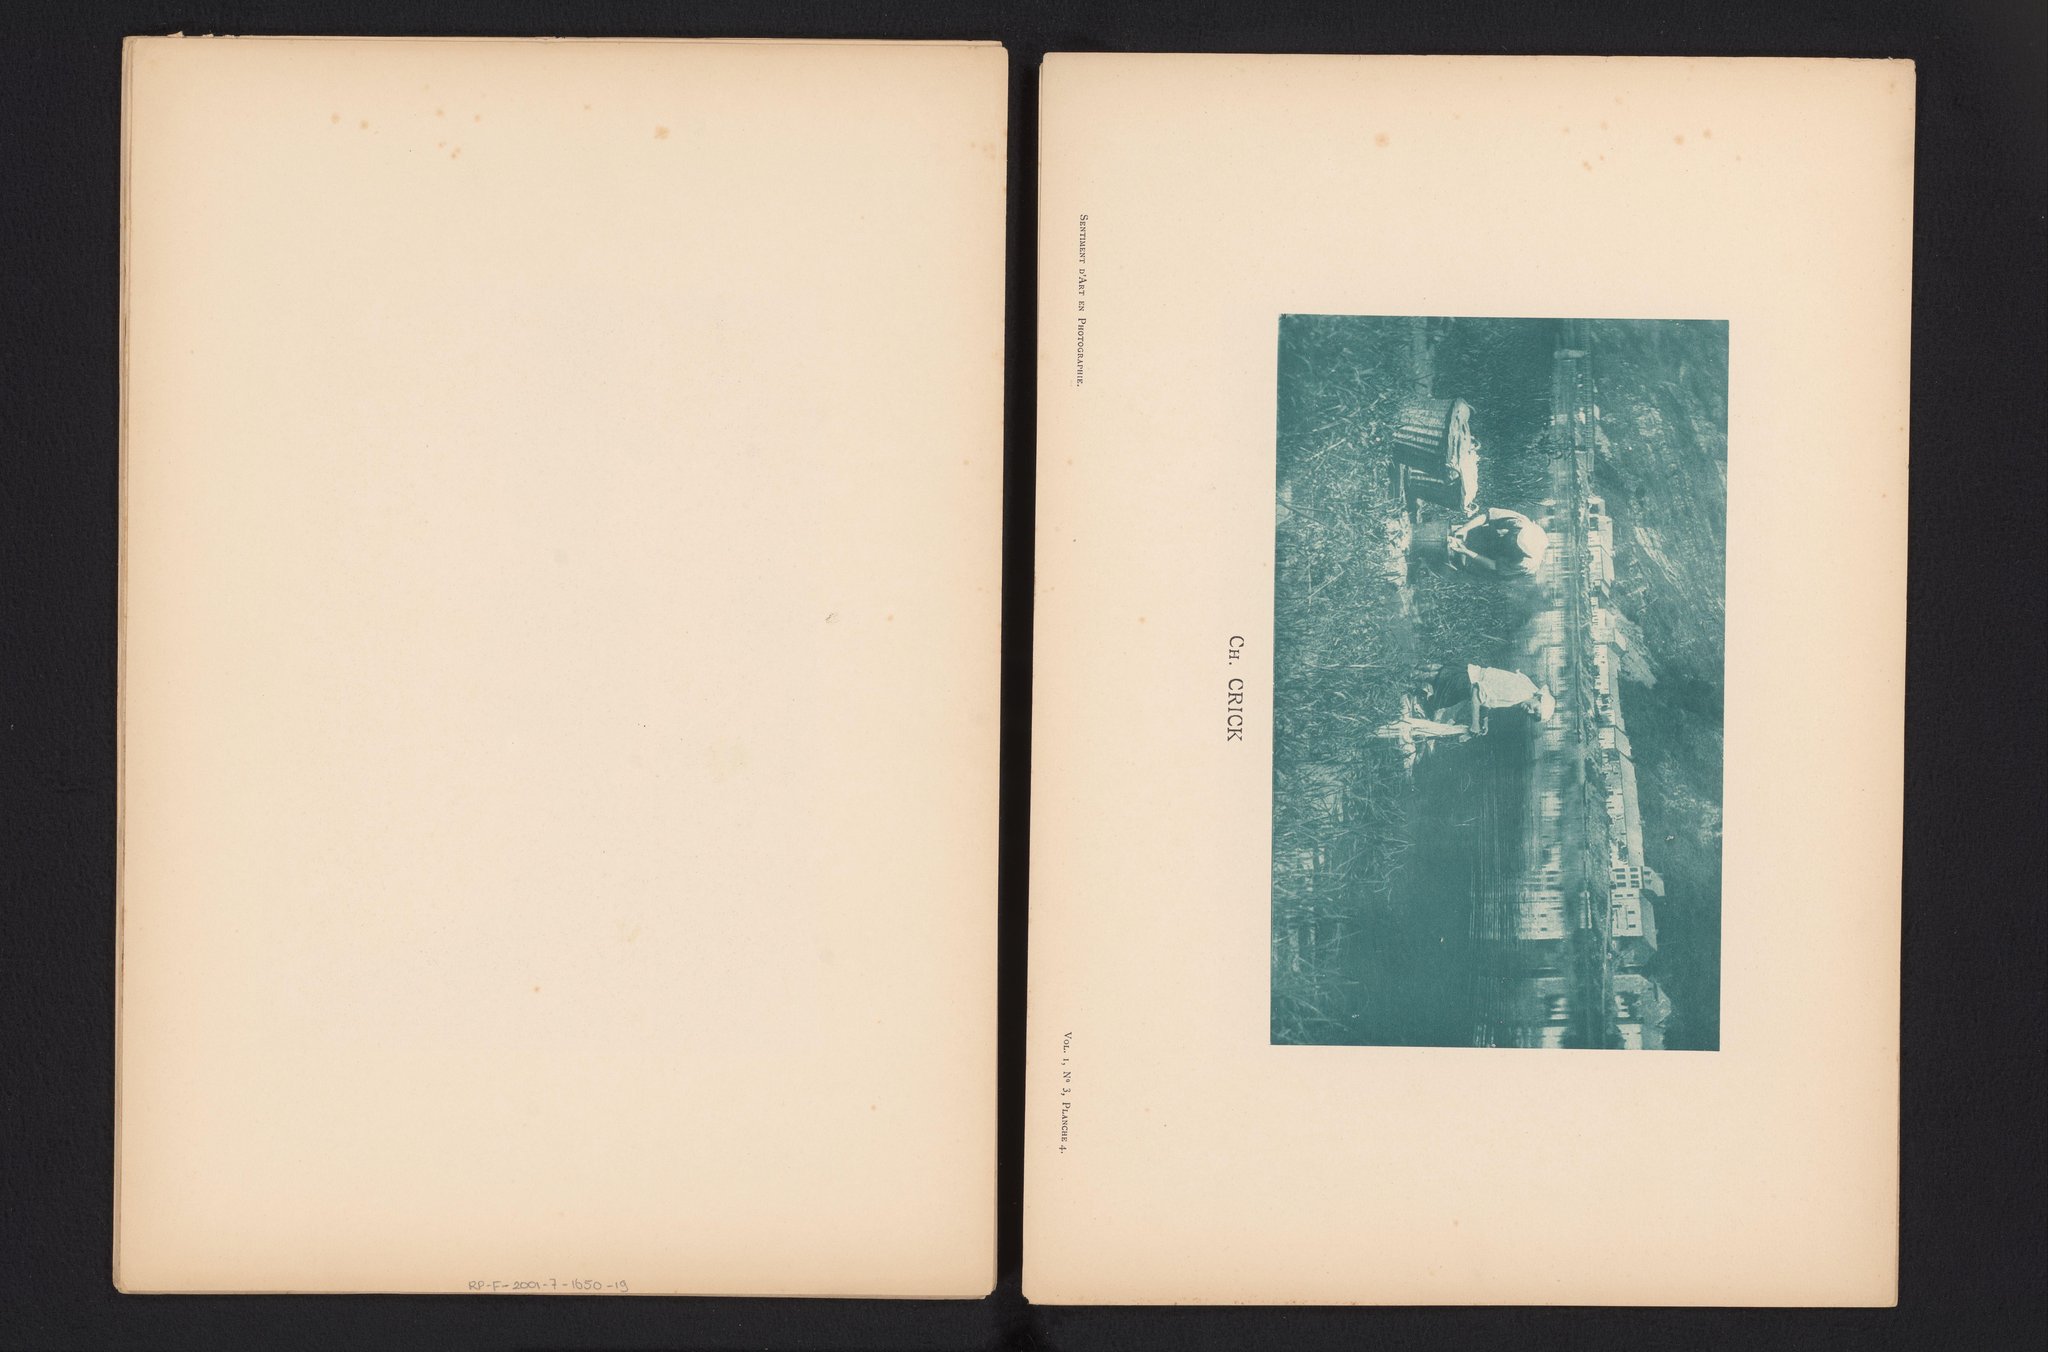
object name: photomechanical print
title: Twee vrouwen wassen kleding aan de oever van een rivier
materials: paper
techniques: photograph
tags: river bank, laundering, adult woman (+ two persons)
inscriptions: number: ‘Vol. 1, No 3, Planche 4.’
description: Deze prent maakt deel uit van 8 omslagen met 22 tekstbladen en 89 prenten op losse bladen in en tussen de omslagen.